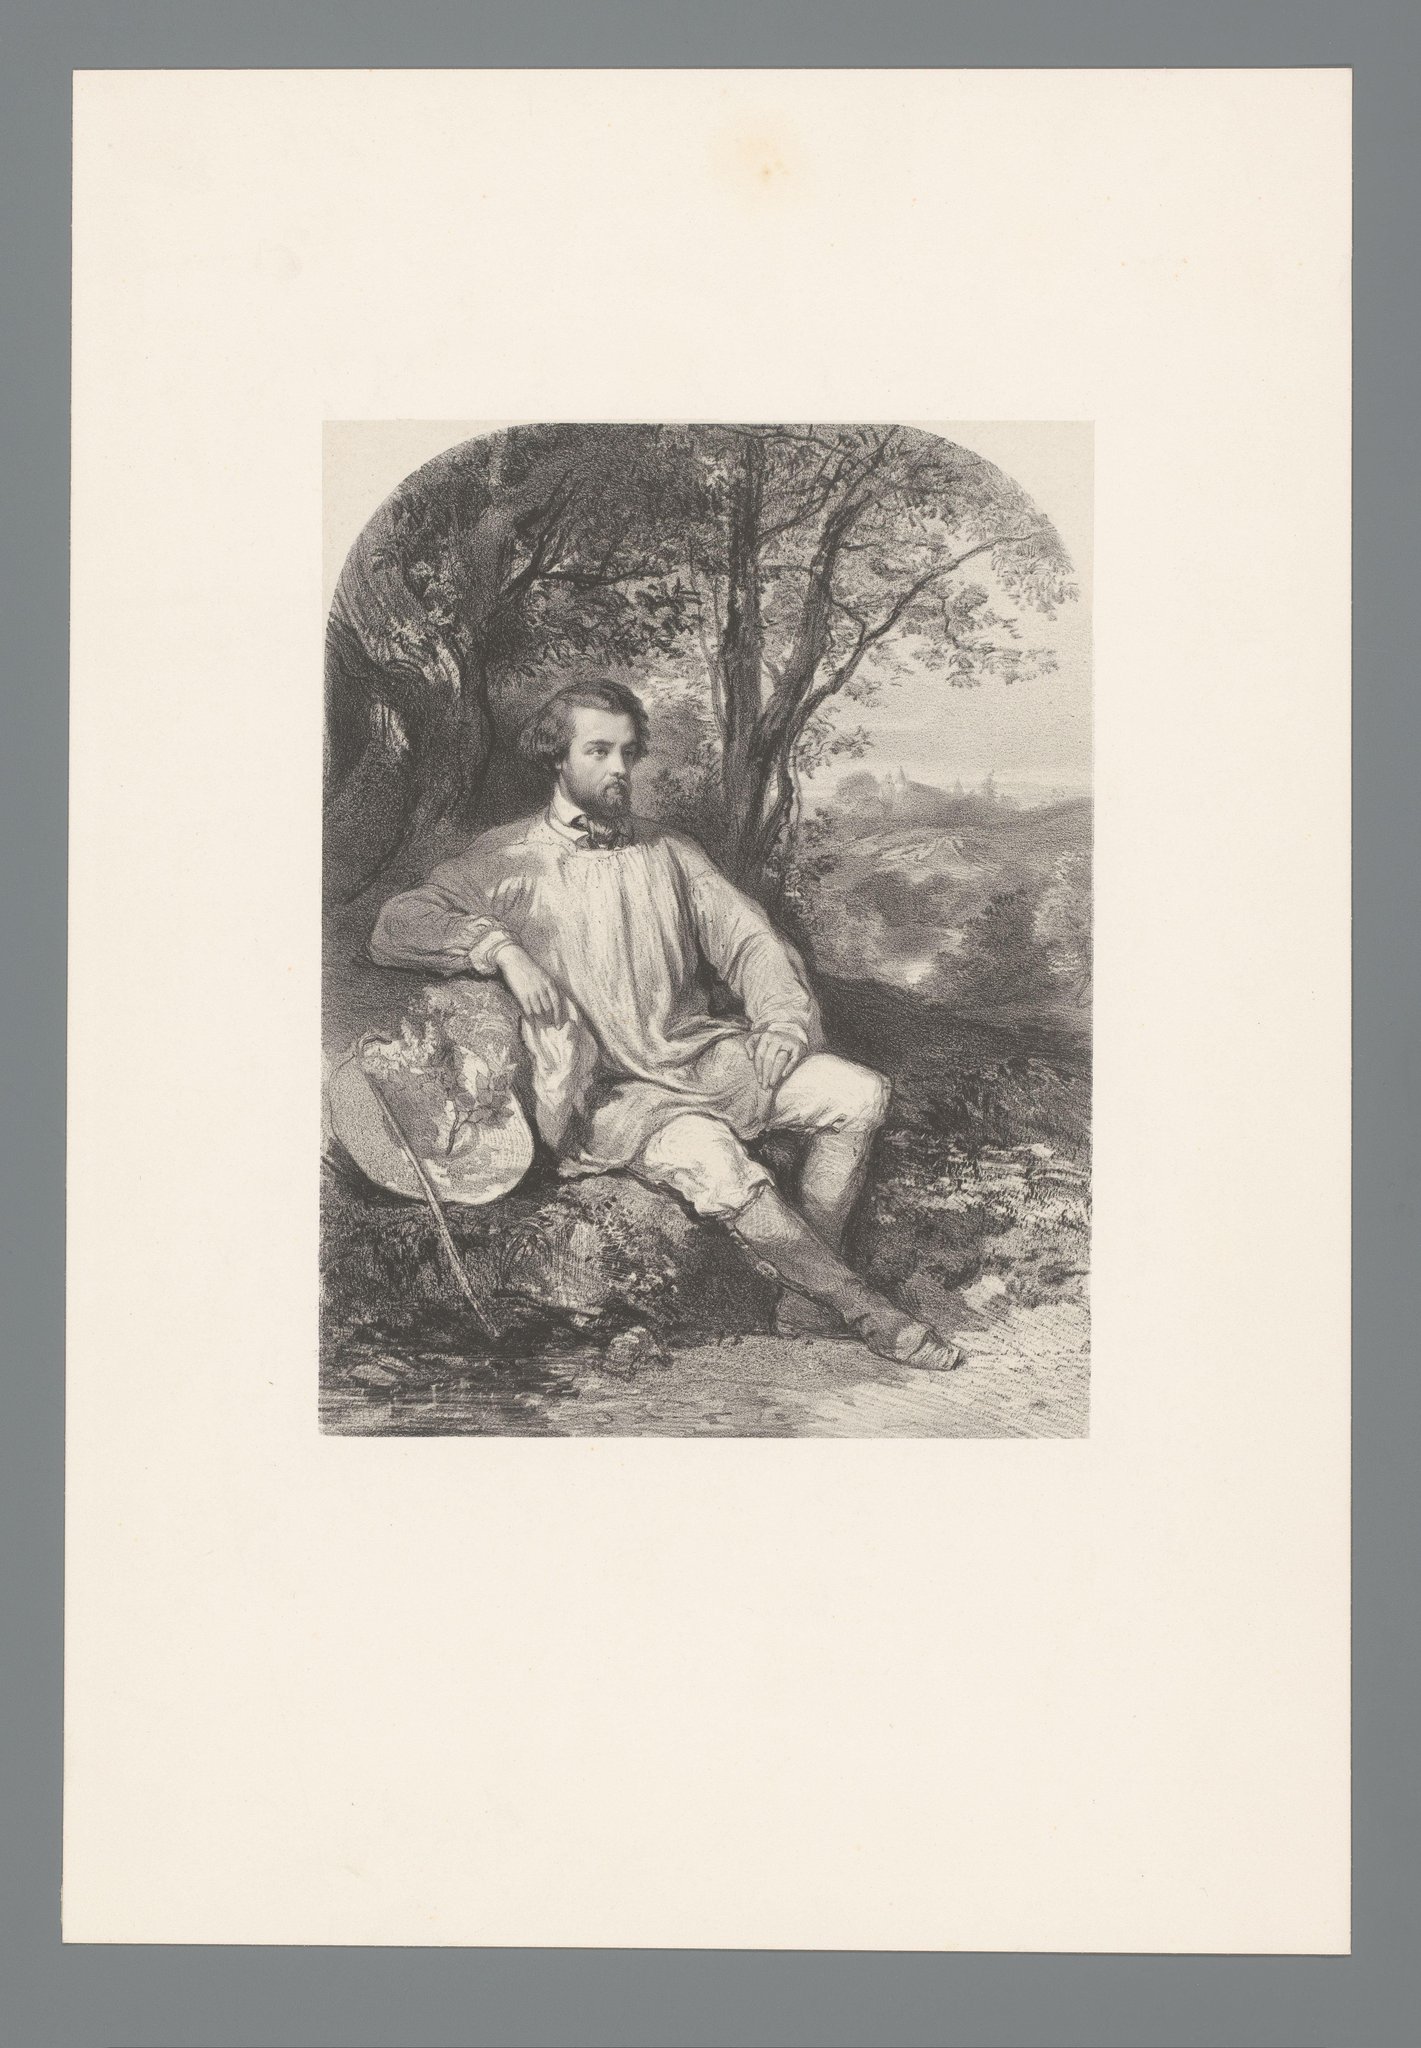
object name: print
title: Portret van een zittende man in schilderskiel in een landschap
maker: adolphe mouilleron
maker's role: draughtsman, print maker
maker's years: 1820-1881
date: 1830-1881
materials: paper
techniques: lithograph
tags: landscapes in the temperate zone - hh - ideal landscapes, adult man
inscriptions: collector's mark: Lugt 2228